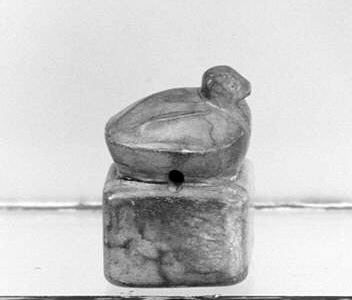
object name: seal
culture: chinese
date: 206 BCE-220 CE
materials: jade